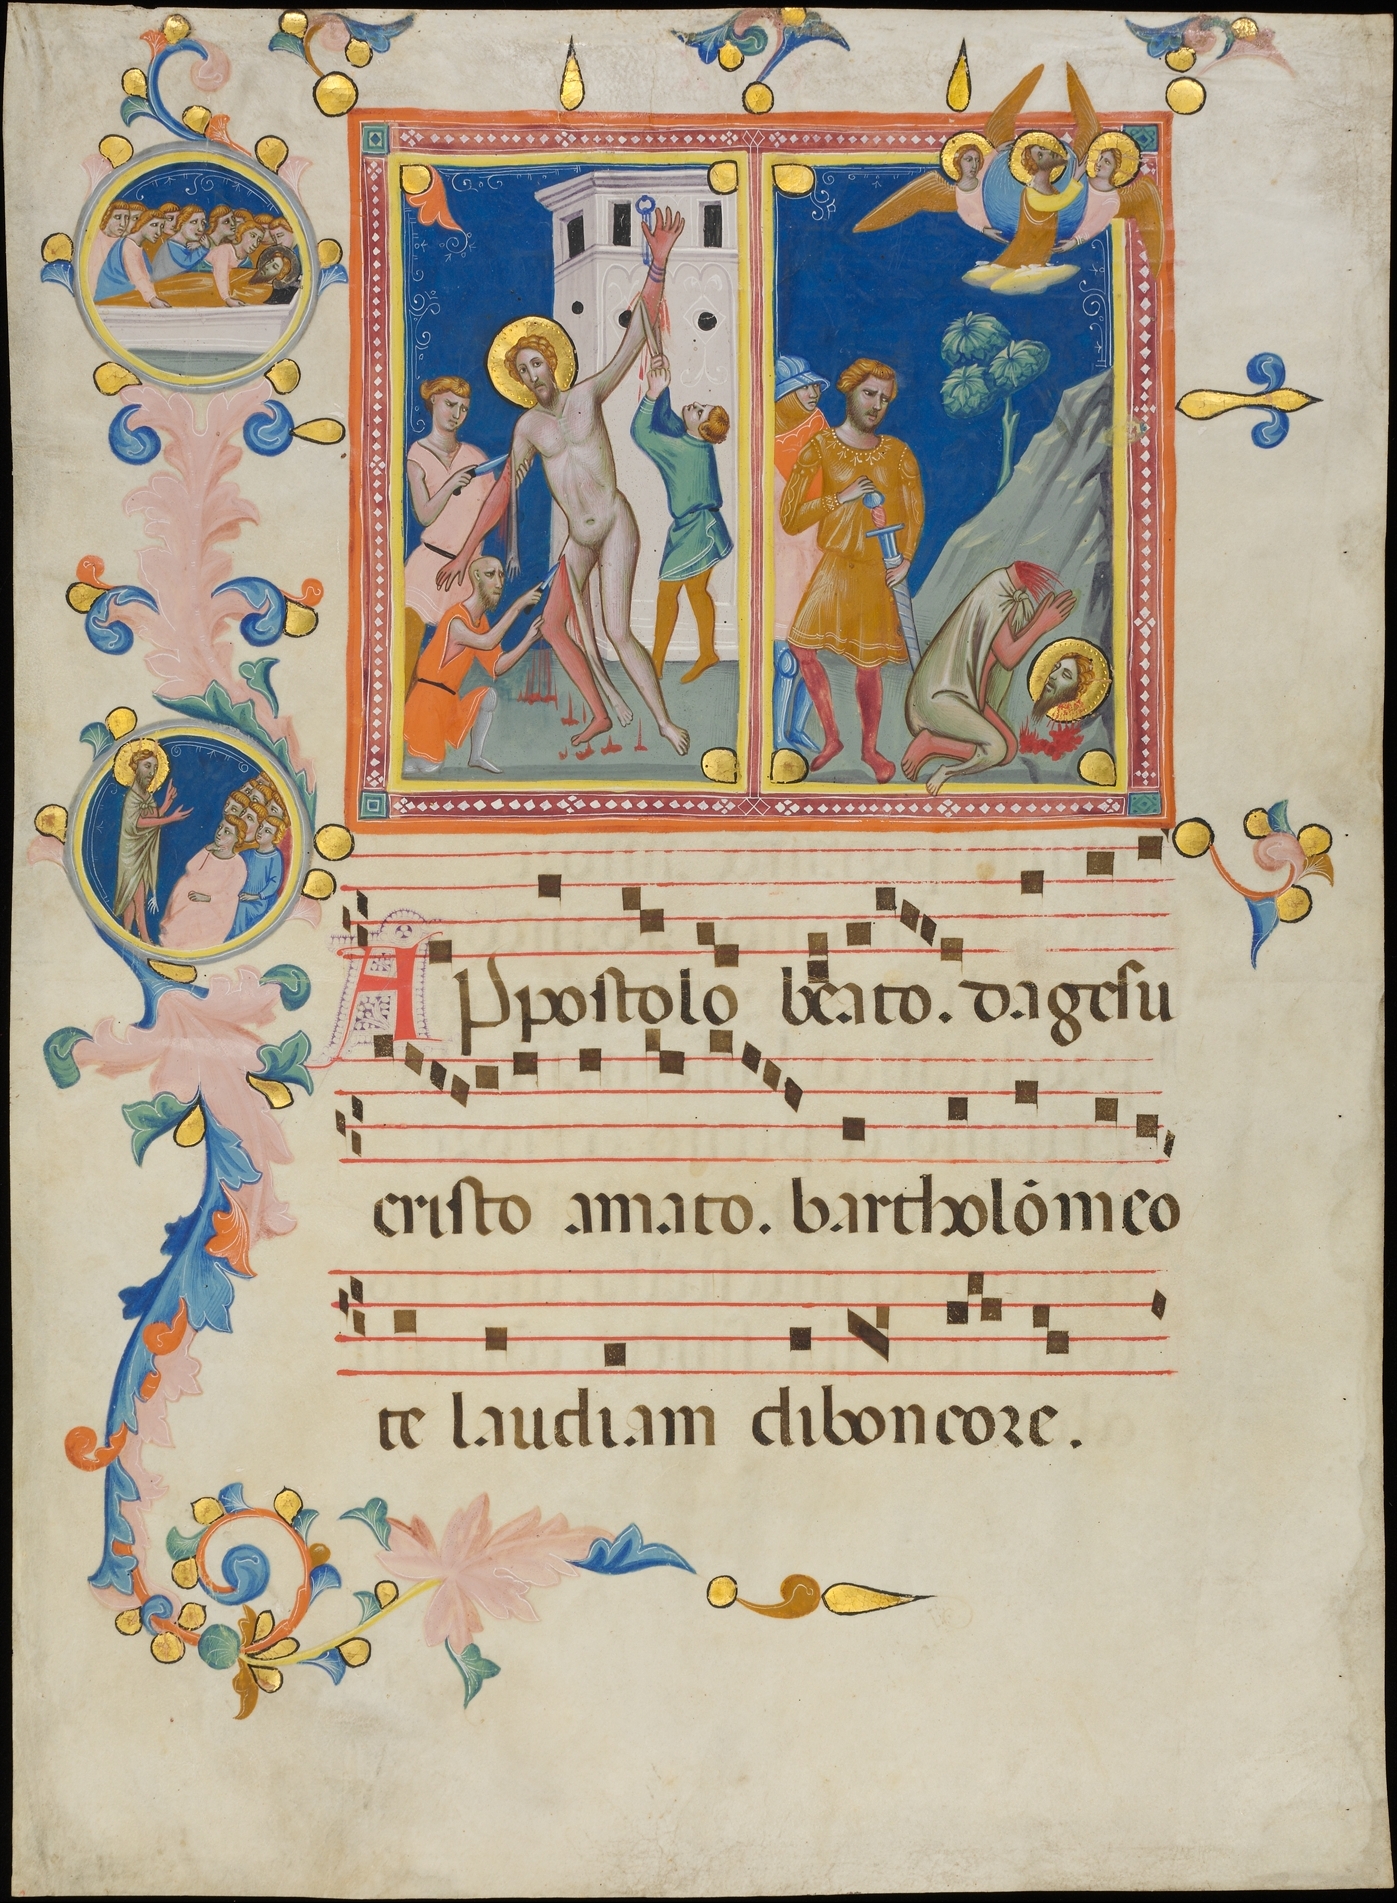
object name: laudario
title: Manuscript Leaf with the Martyrdom of Saint Bartholomew, from a Laudario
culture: italian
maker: pacino di bonaguida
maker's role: artist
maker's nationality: italian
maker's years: 1302-1340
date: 1340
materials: gold, ink, parchment, paint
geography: italy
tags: men,angels,saints